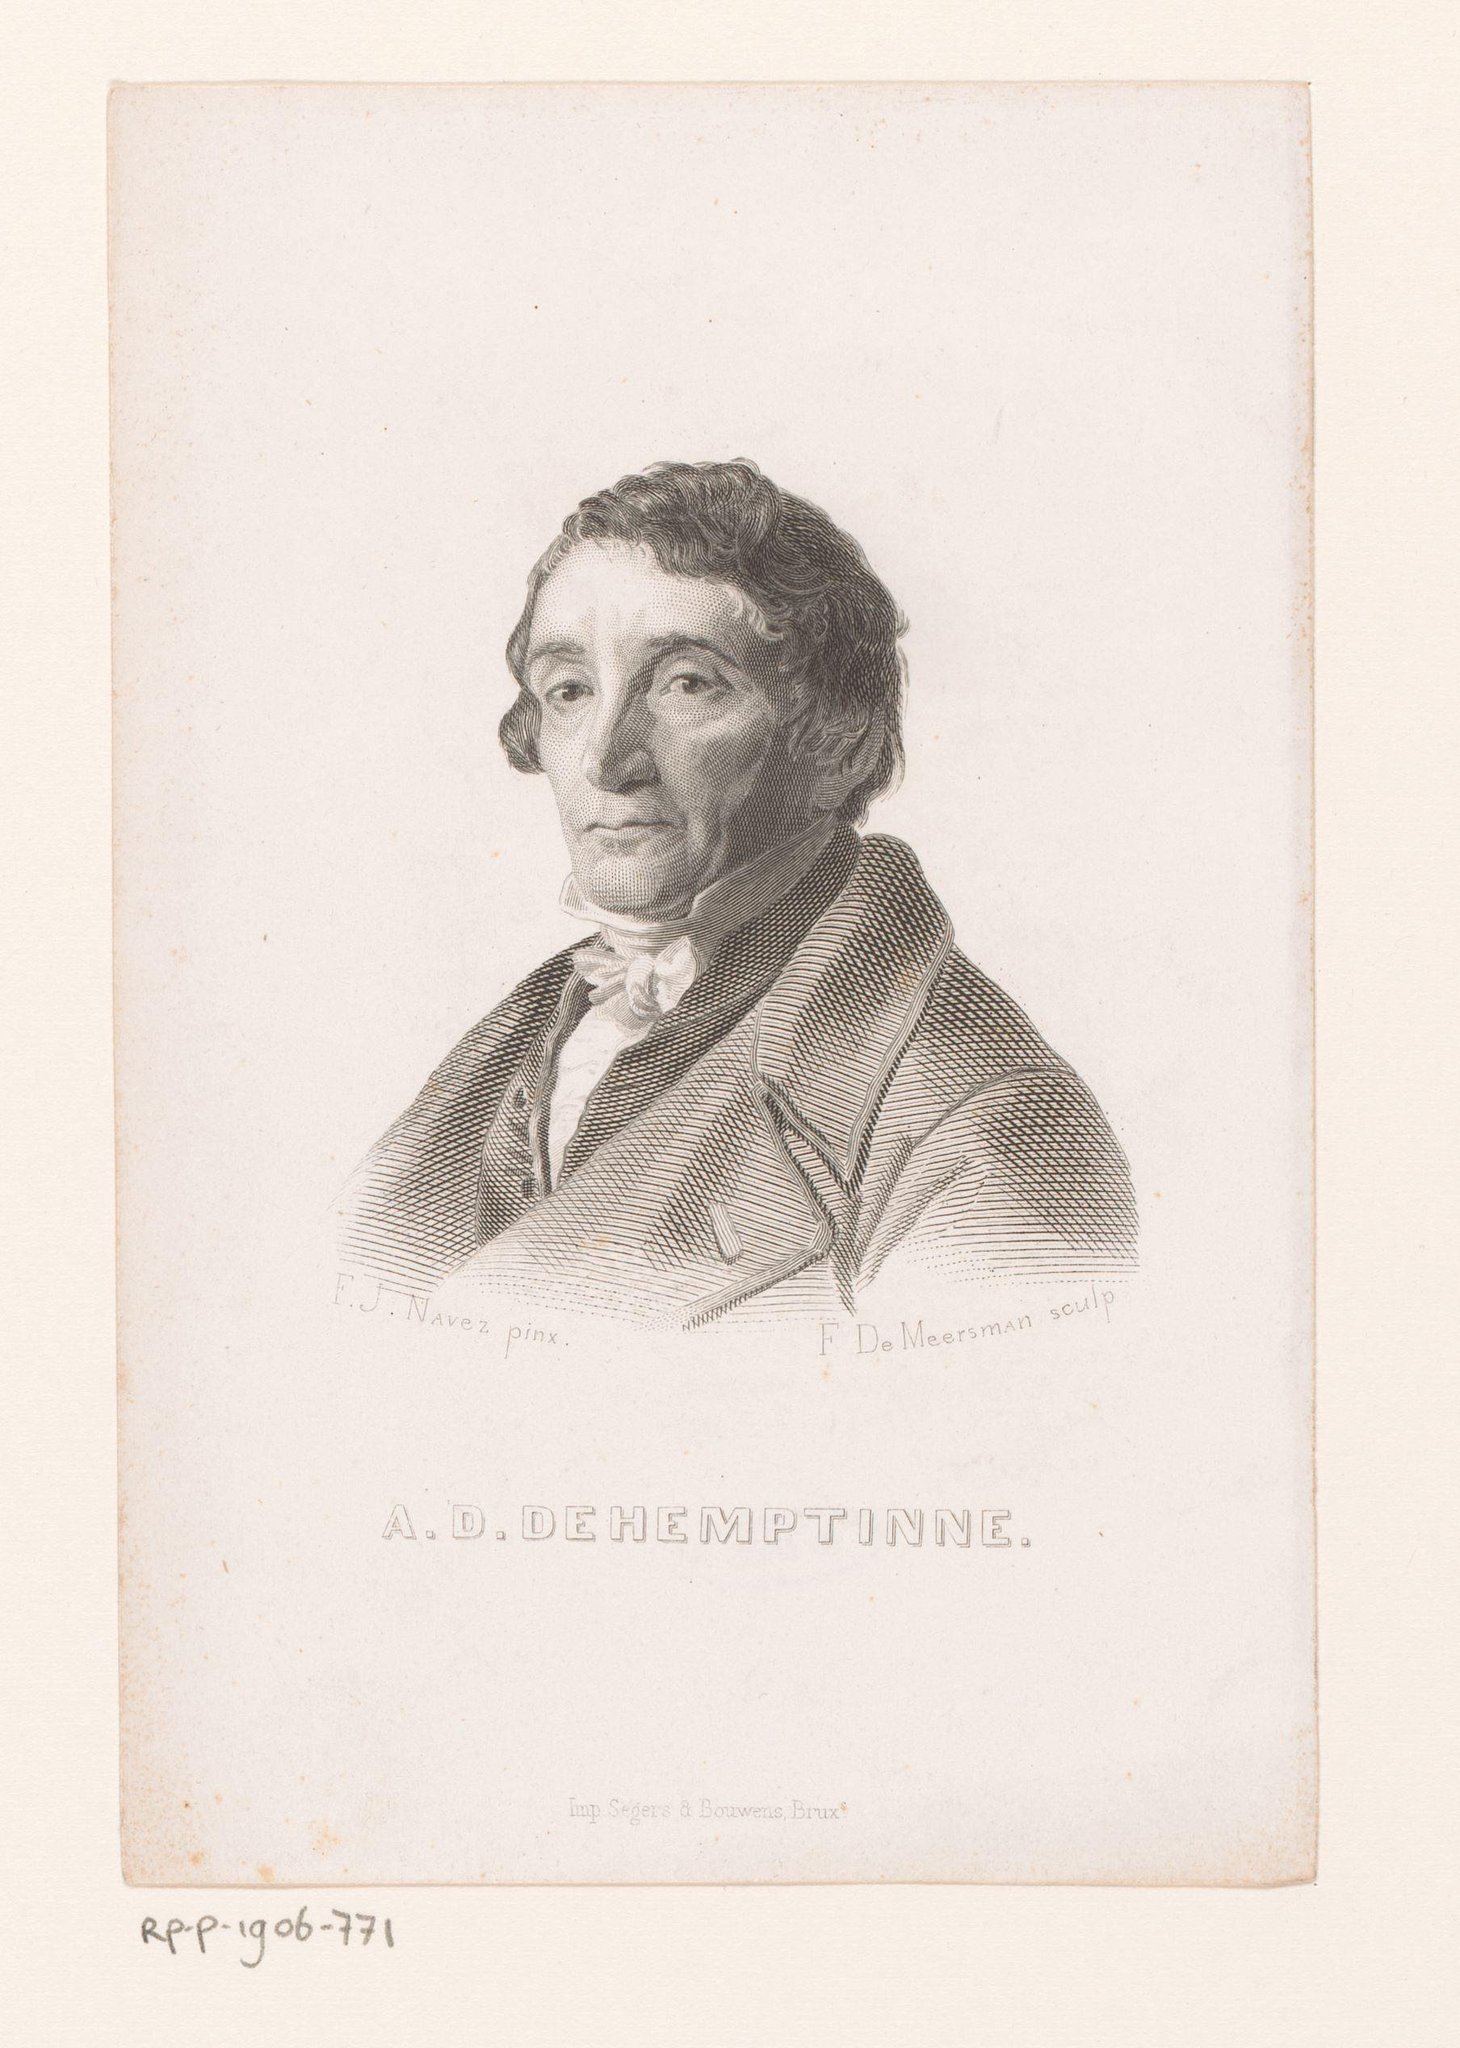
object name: print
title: A.D. Dehemptinne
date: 1840-1905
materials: paper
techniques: engraving, etching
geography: brussels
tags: adult man, historical persons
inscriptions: collector's mark: Lugt 2228